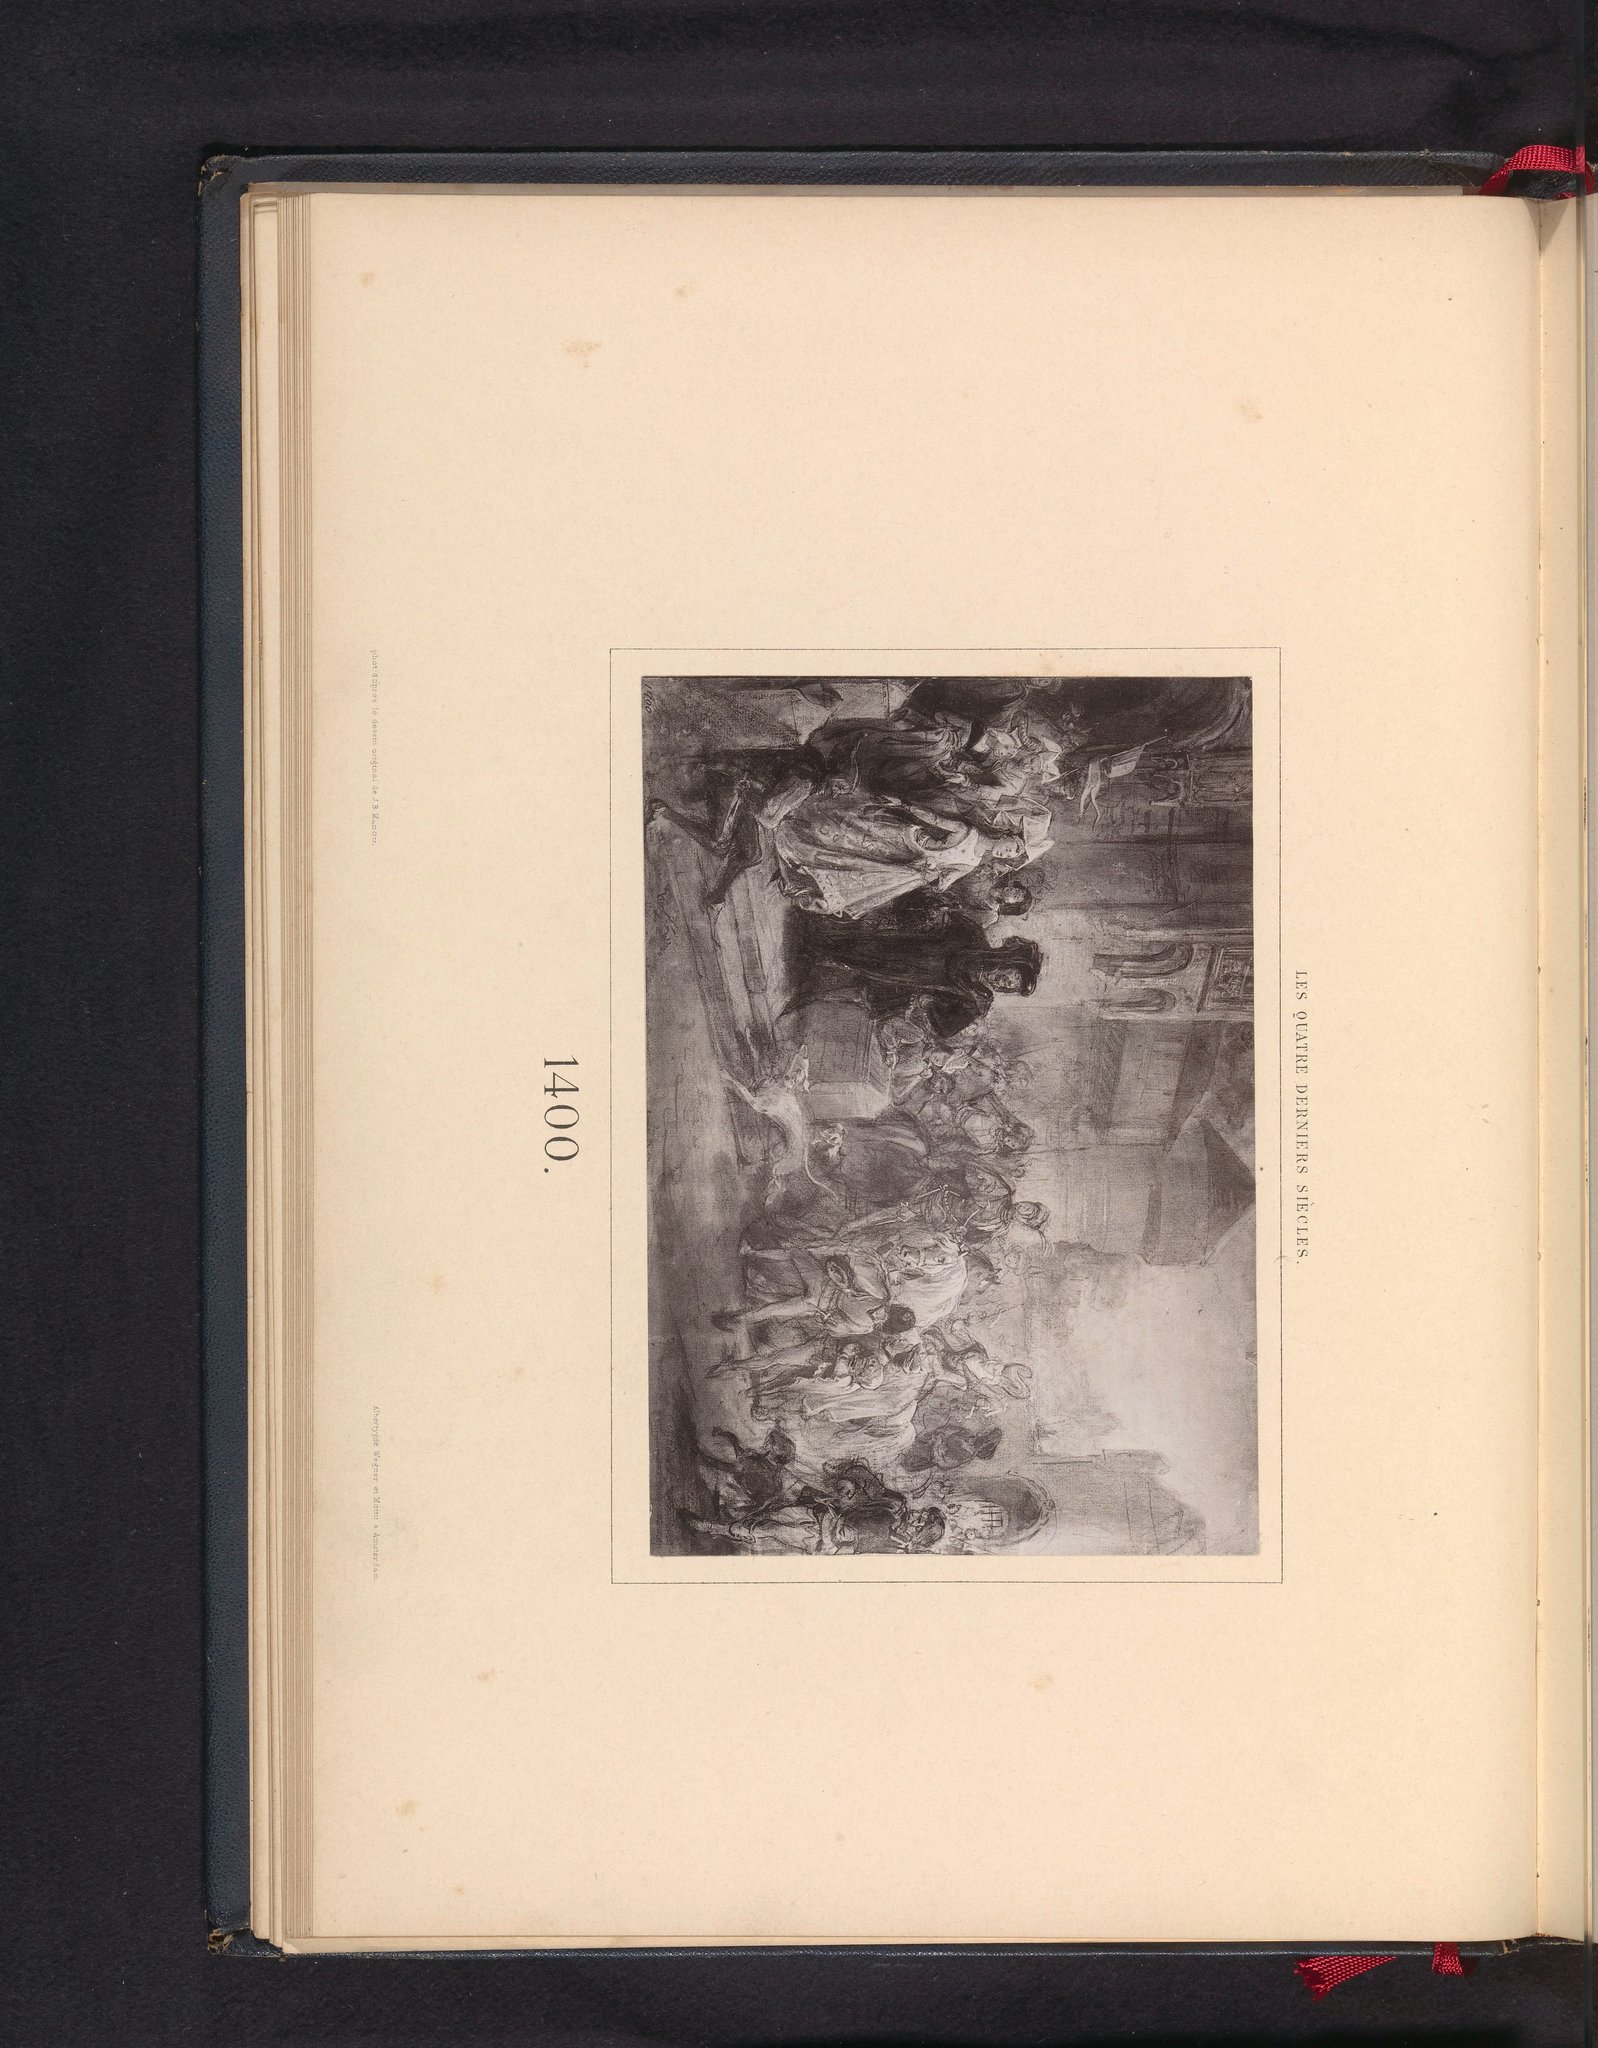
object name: photomechanical print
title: 1400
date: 1868-1873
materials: paper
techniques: photograph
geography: amsterdam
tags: triumphal entry and public reception, pageant, 'entrée solennelle', 'joyeuse entrée', nobility and patriciate; chivalry, knighthood